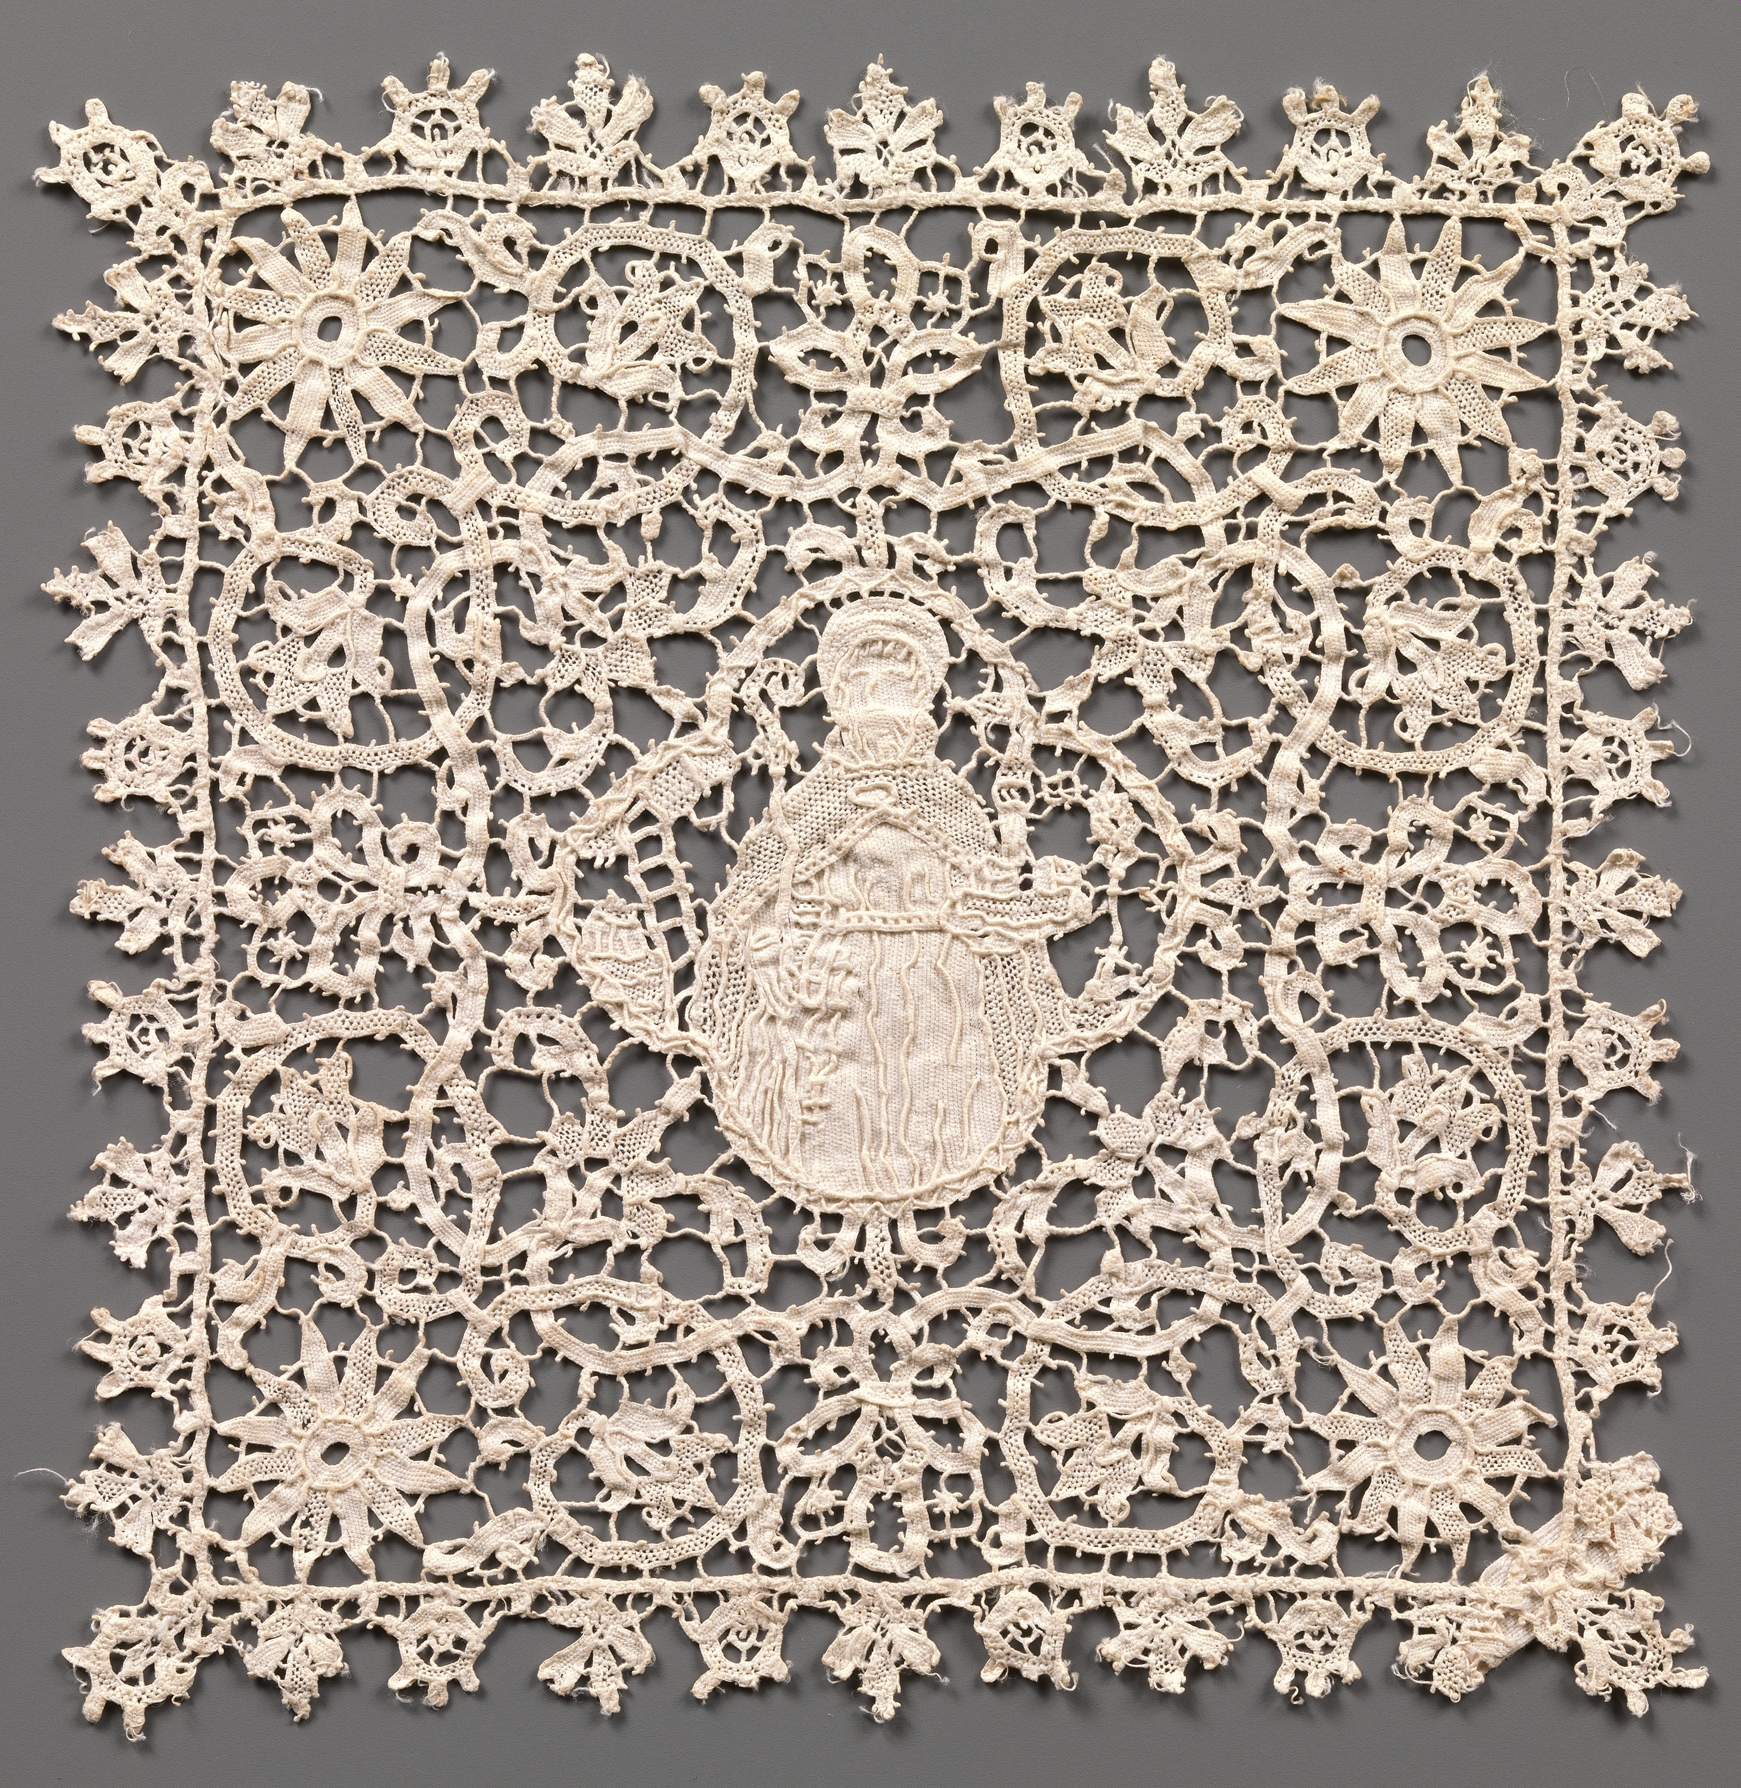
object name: chalice cover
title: Chalice veil depicting Saint Blaise, patron saint of Dubrovnik.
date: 1501-1600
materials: linen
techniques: lace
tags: saints